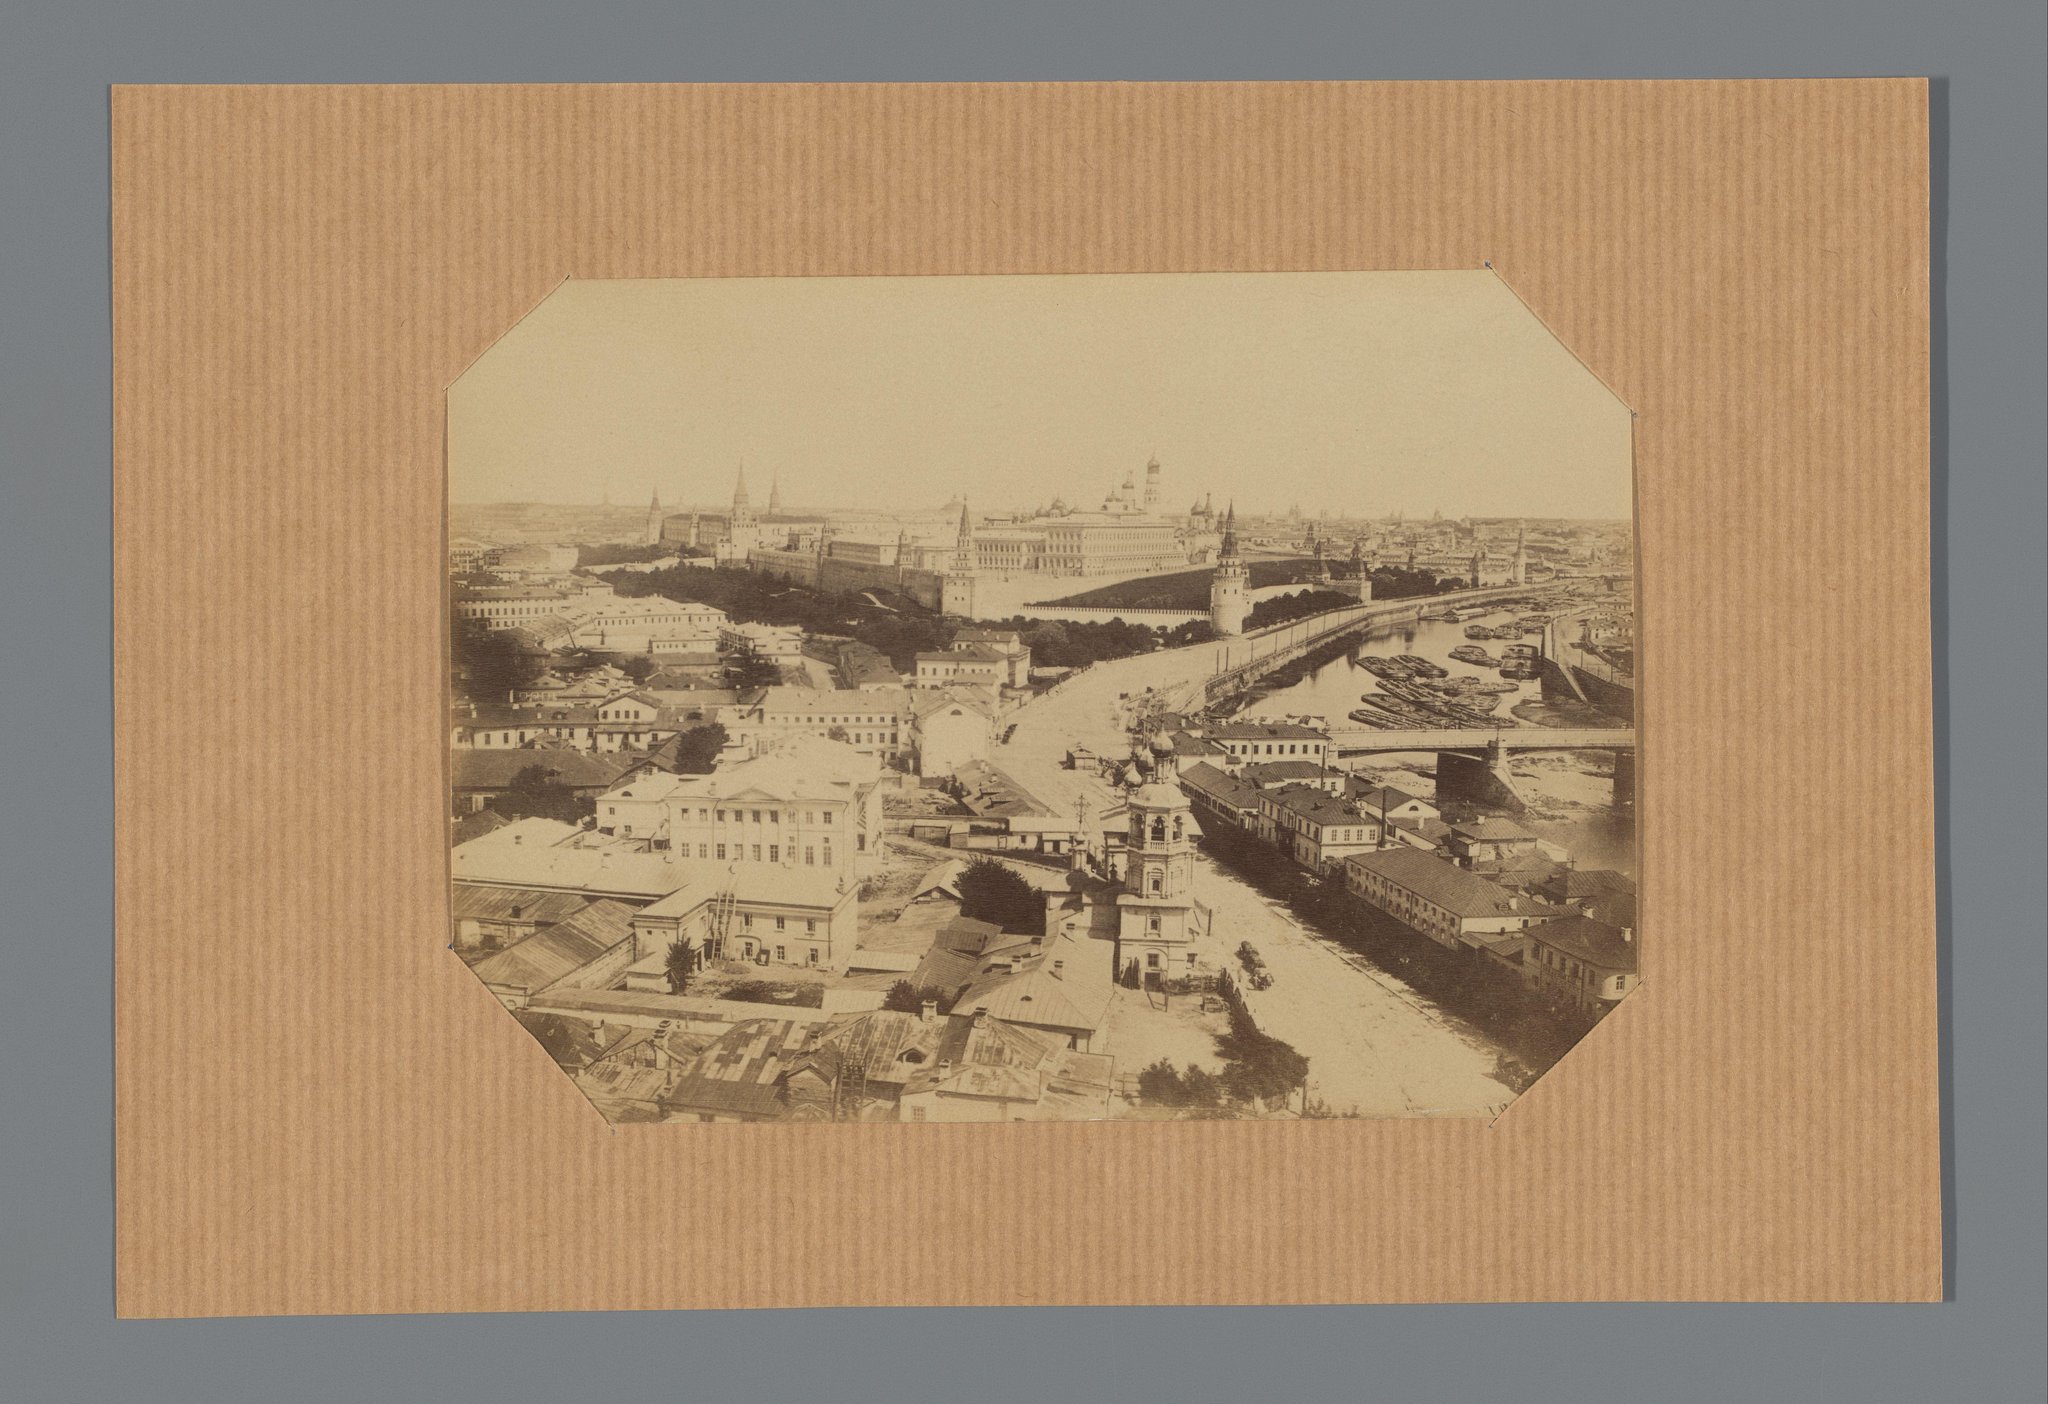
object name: photograph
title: Moskou. Gezicht van Kremlin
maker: Anonymous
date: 1850-1900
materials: photographic support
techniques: albumen print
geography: russia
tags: moskou